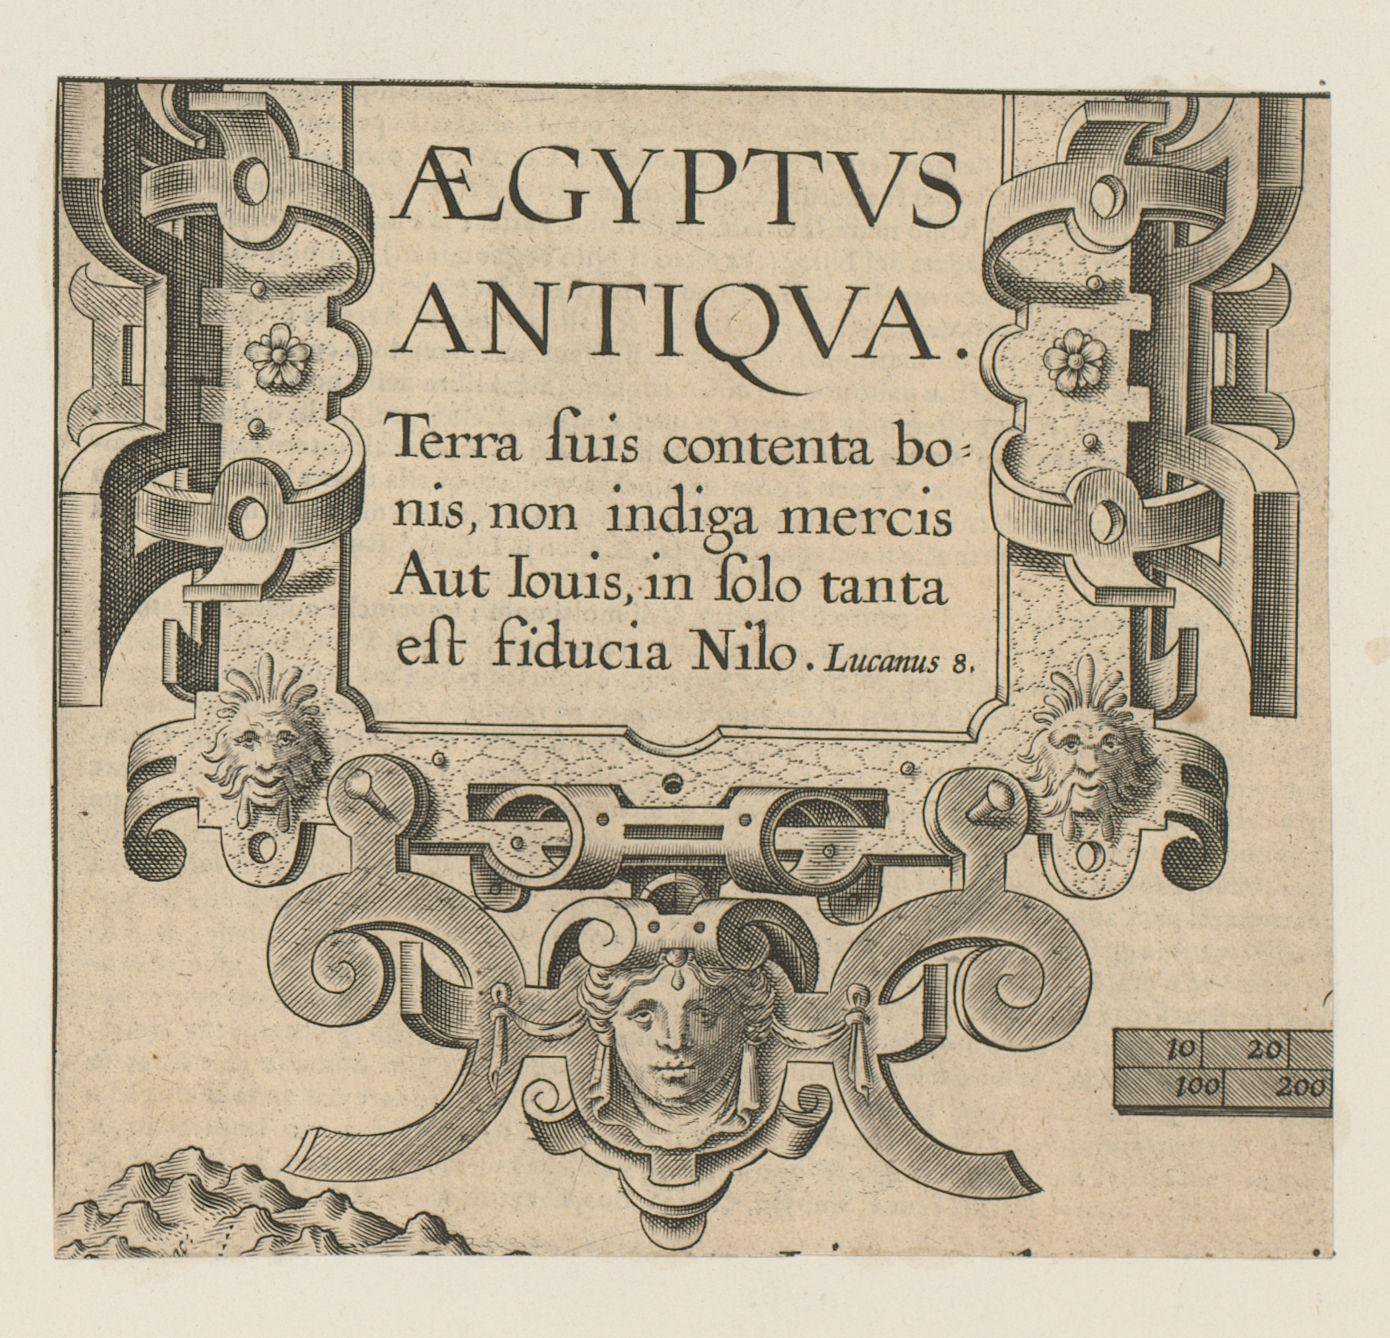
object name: ornament print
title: Aegyptus Antiqua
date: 1595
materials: paper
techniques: engraving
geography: antwerp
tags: scrollwork, strapwork ~ ornament, ornament ~ cartouche, mask, mascaron ~ ornament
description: Rechthoekige cartouche met rolwerk en maskers. De cartouche is een fragment van een kaart van het oude Egypte. De prent maakt deel uit van een album.